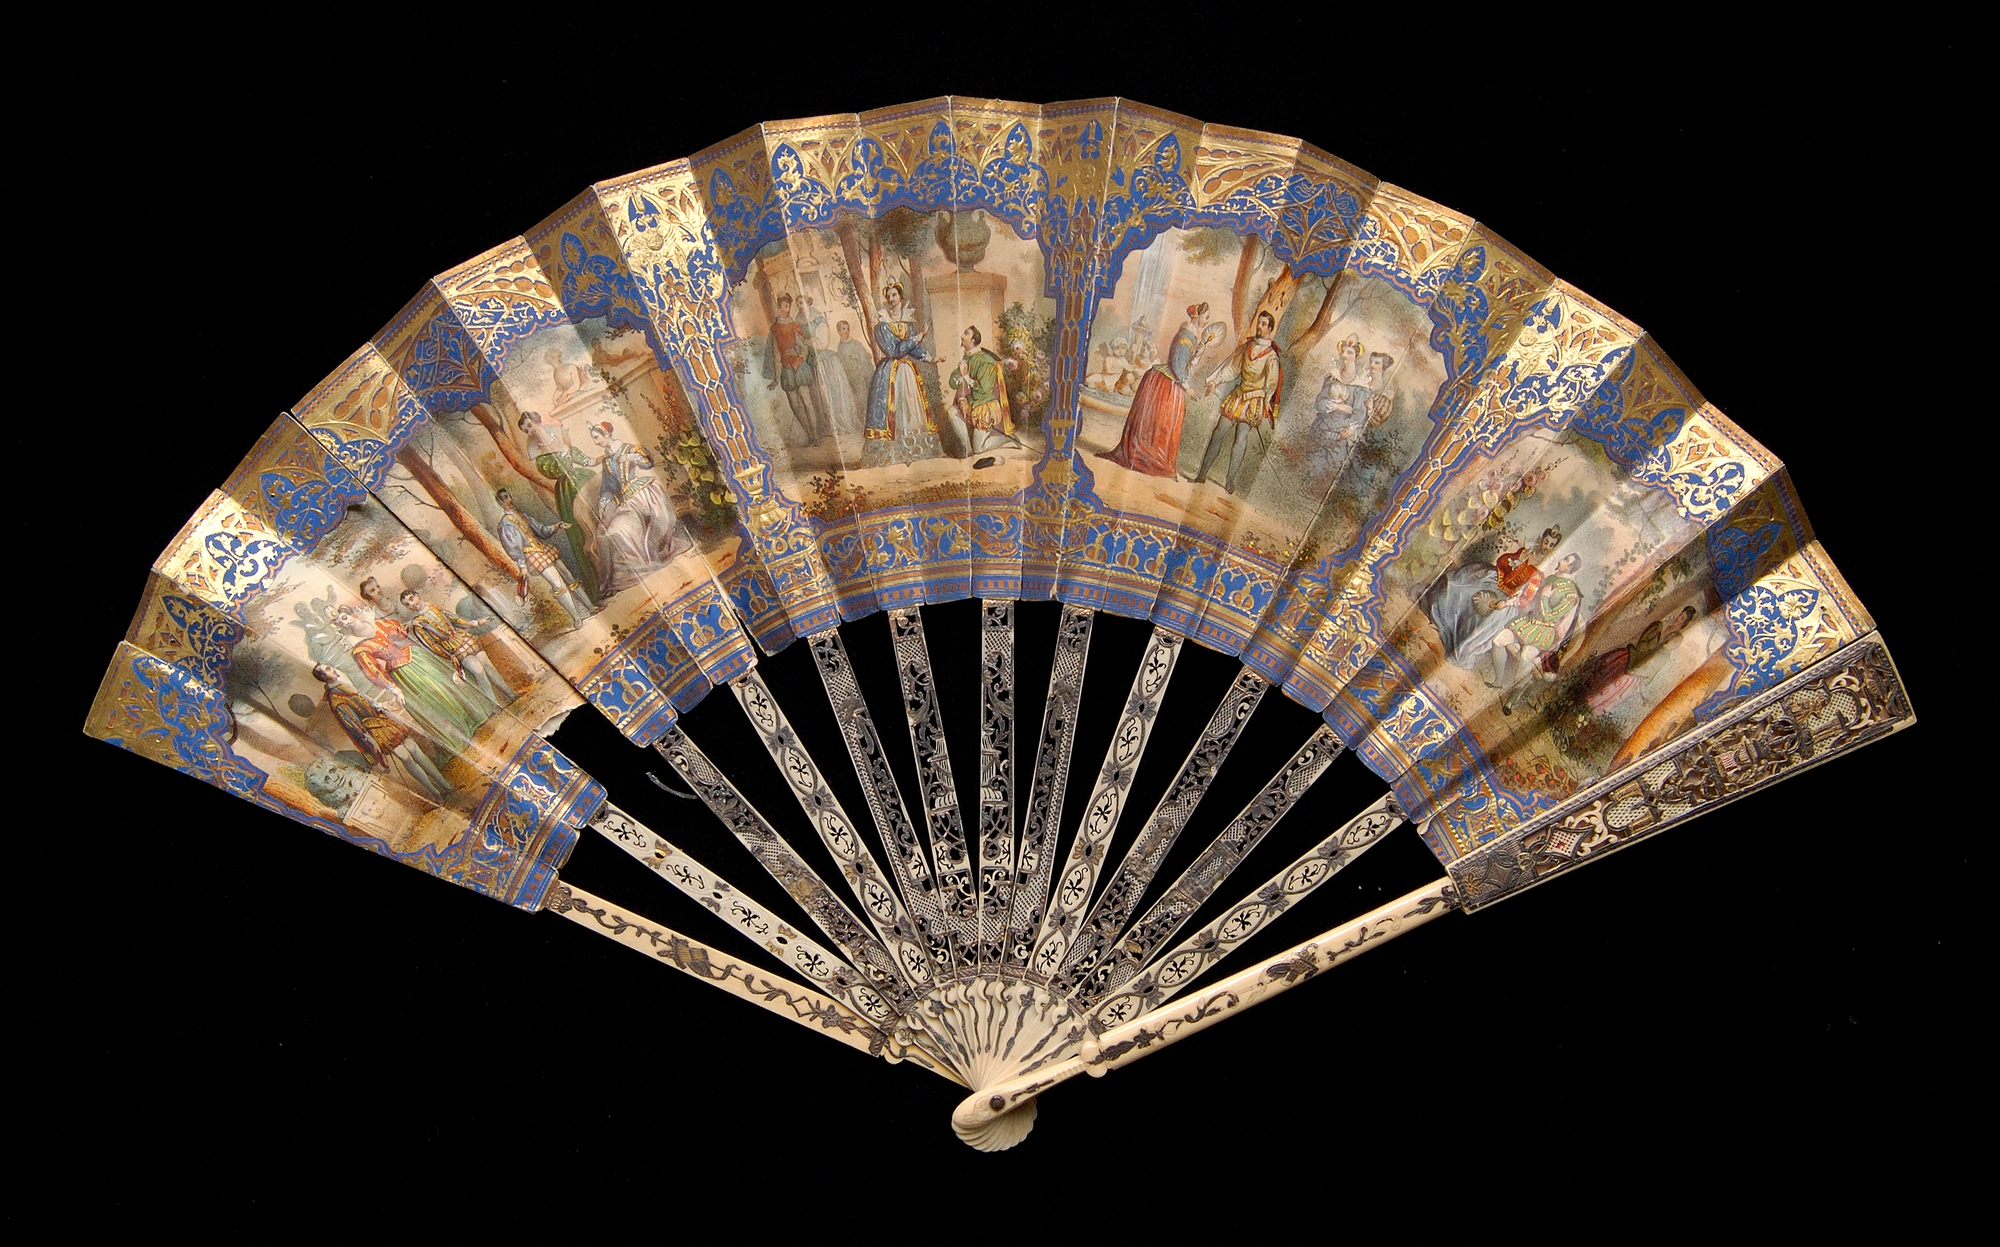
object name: fan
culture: european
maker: eugene andré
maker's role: lithographer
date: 1840-1859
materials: ivory, metal, mother of pearl, paper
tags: men,women